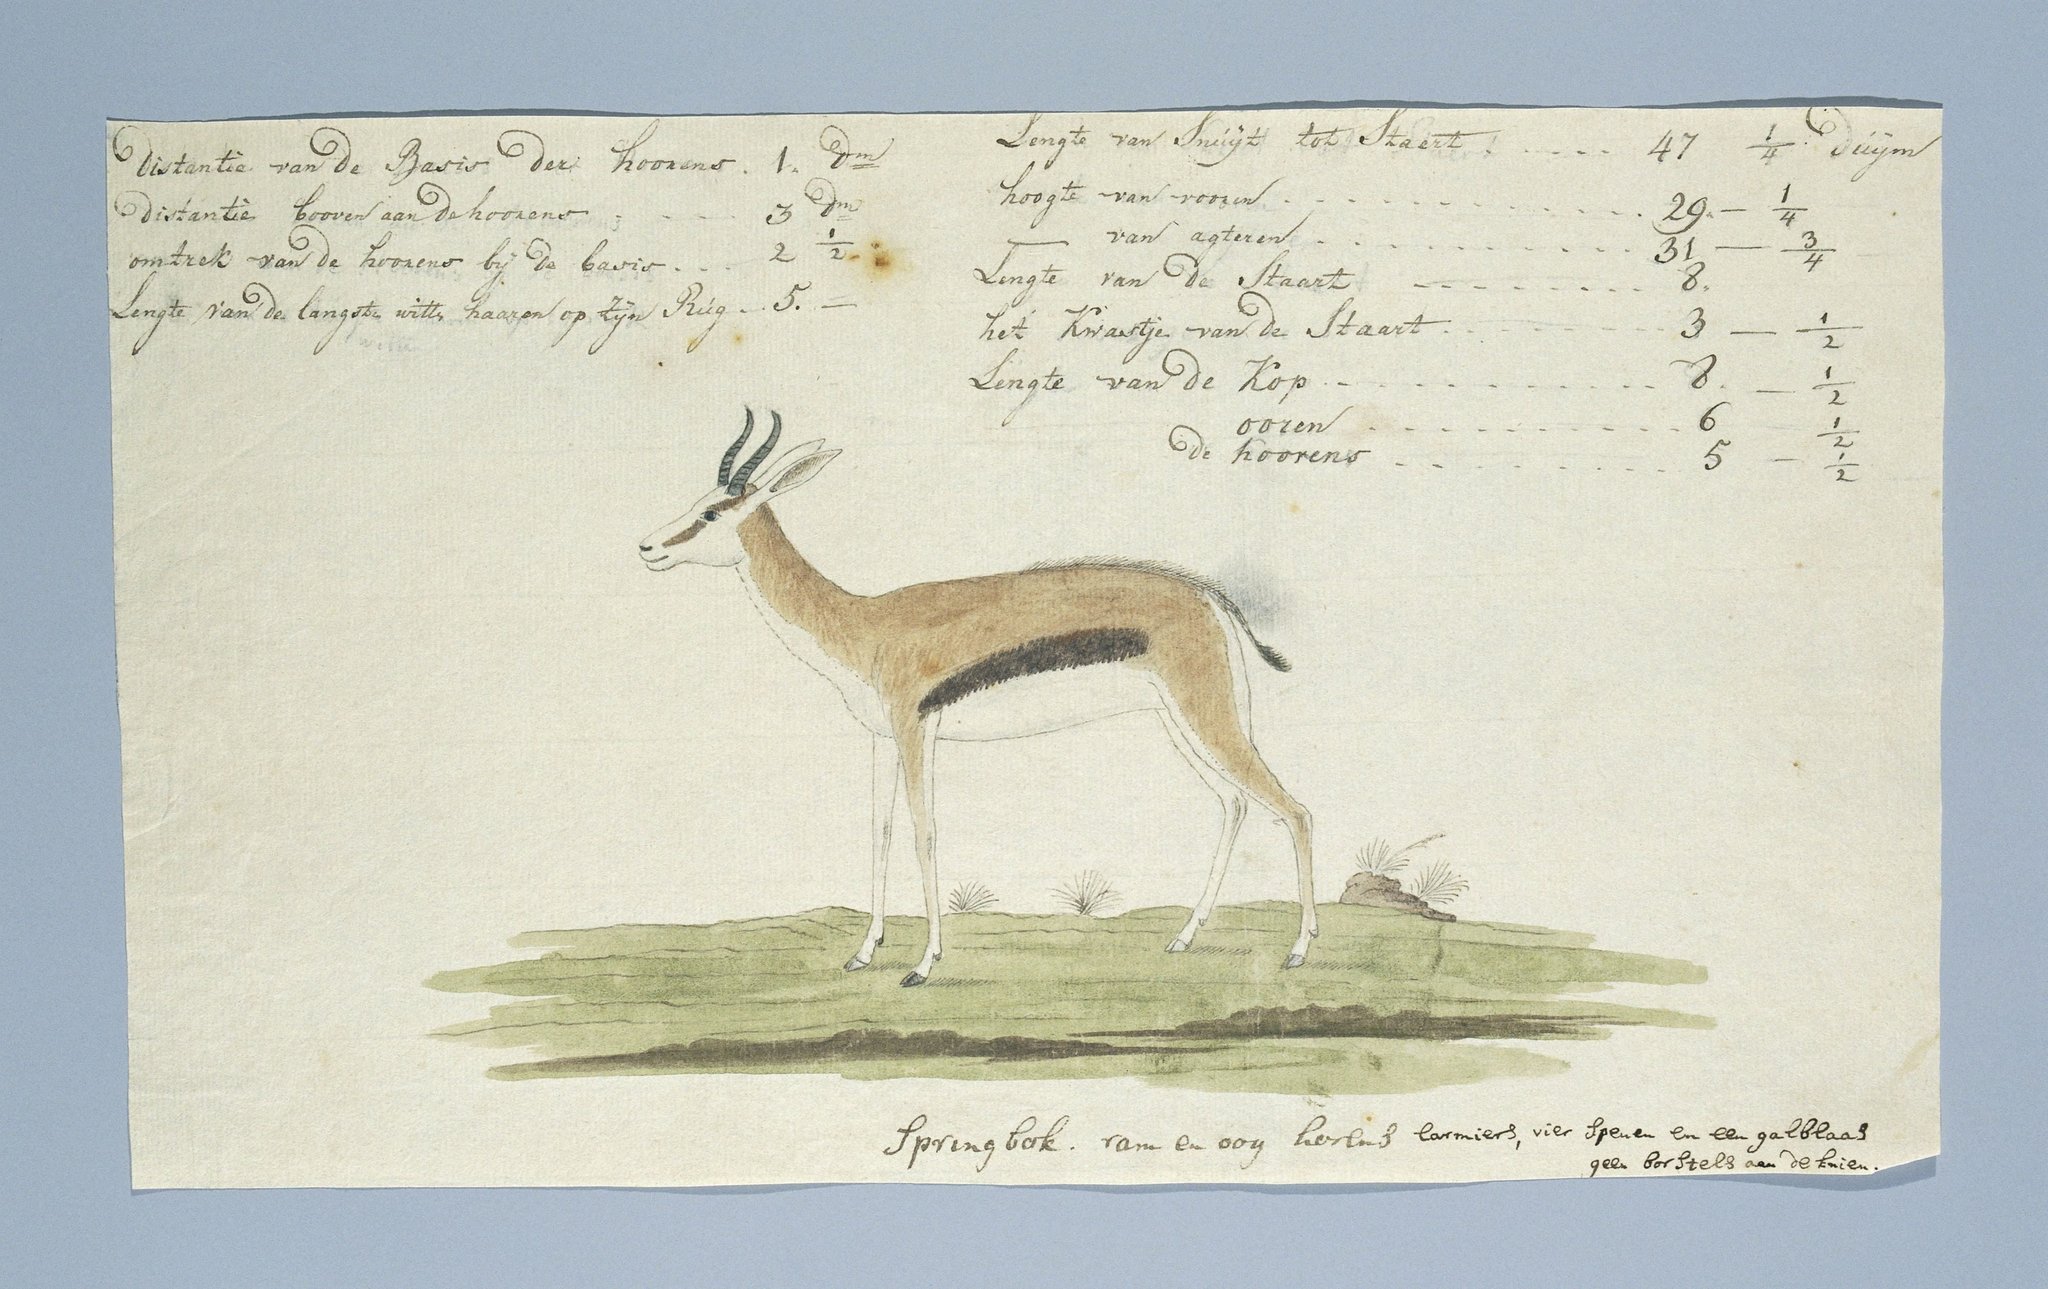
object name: drawing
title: Antidorcas marsupialis (Springbok)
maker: robert jacob gordon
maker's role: draughtsman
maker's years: 1743-1795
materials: chalk, ink, paper, pencil, watercolor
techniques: brush, pen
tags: animals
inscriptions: annotation: ‘beschrijving en afmetingen van de bok in duim (zonder schaalverdeling)’